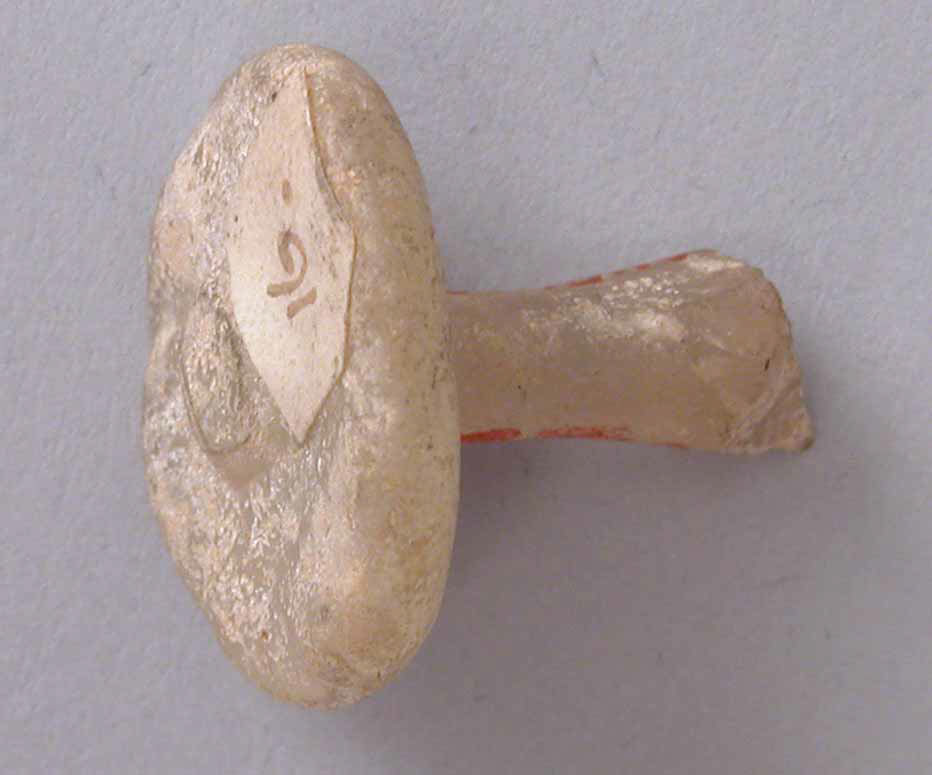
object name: cup, fragment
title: Fragment of a Cup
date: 801-900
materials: glass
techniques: glassblowing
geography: iraq